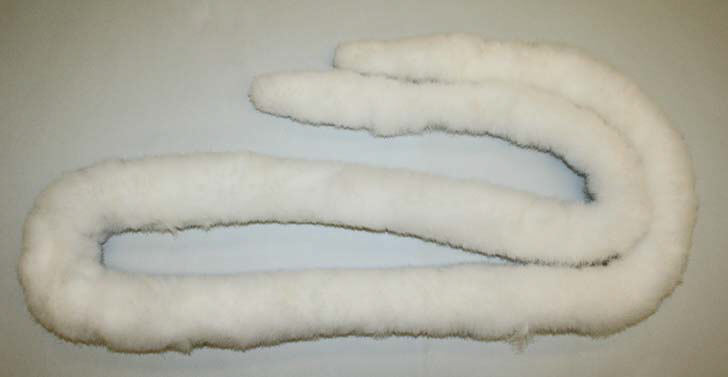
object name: boa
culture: european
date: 1795-1820